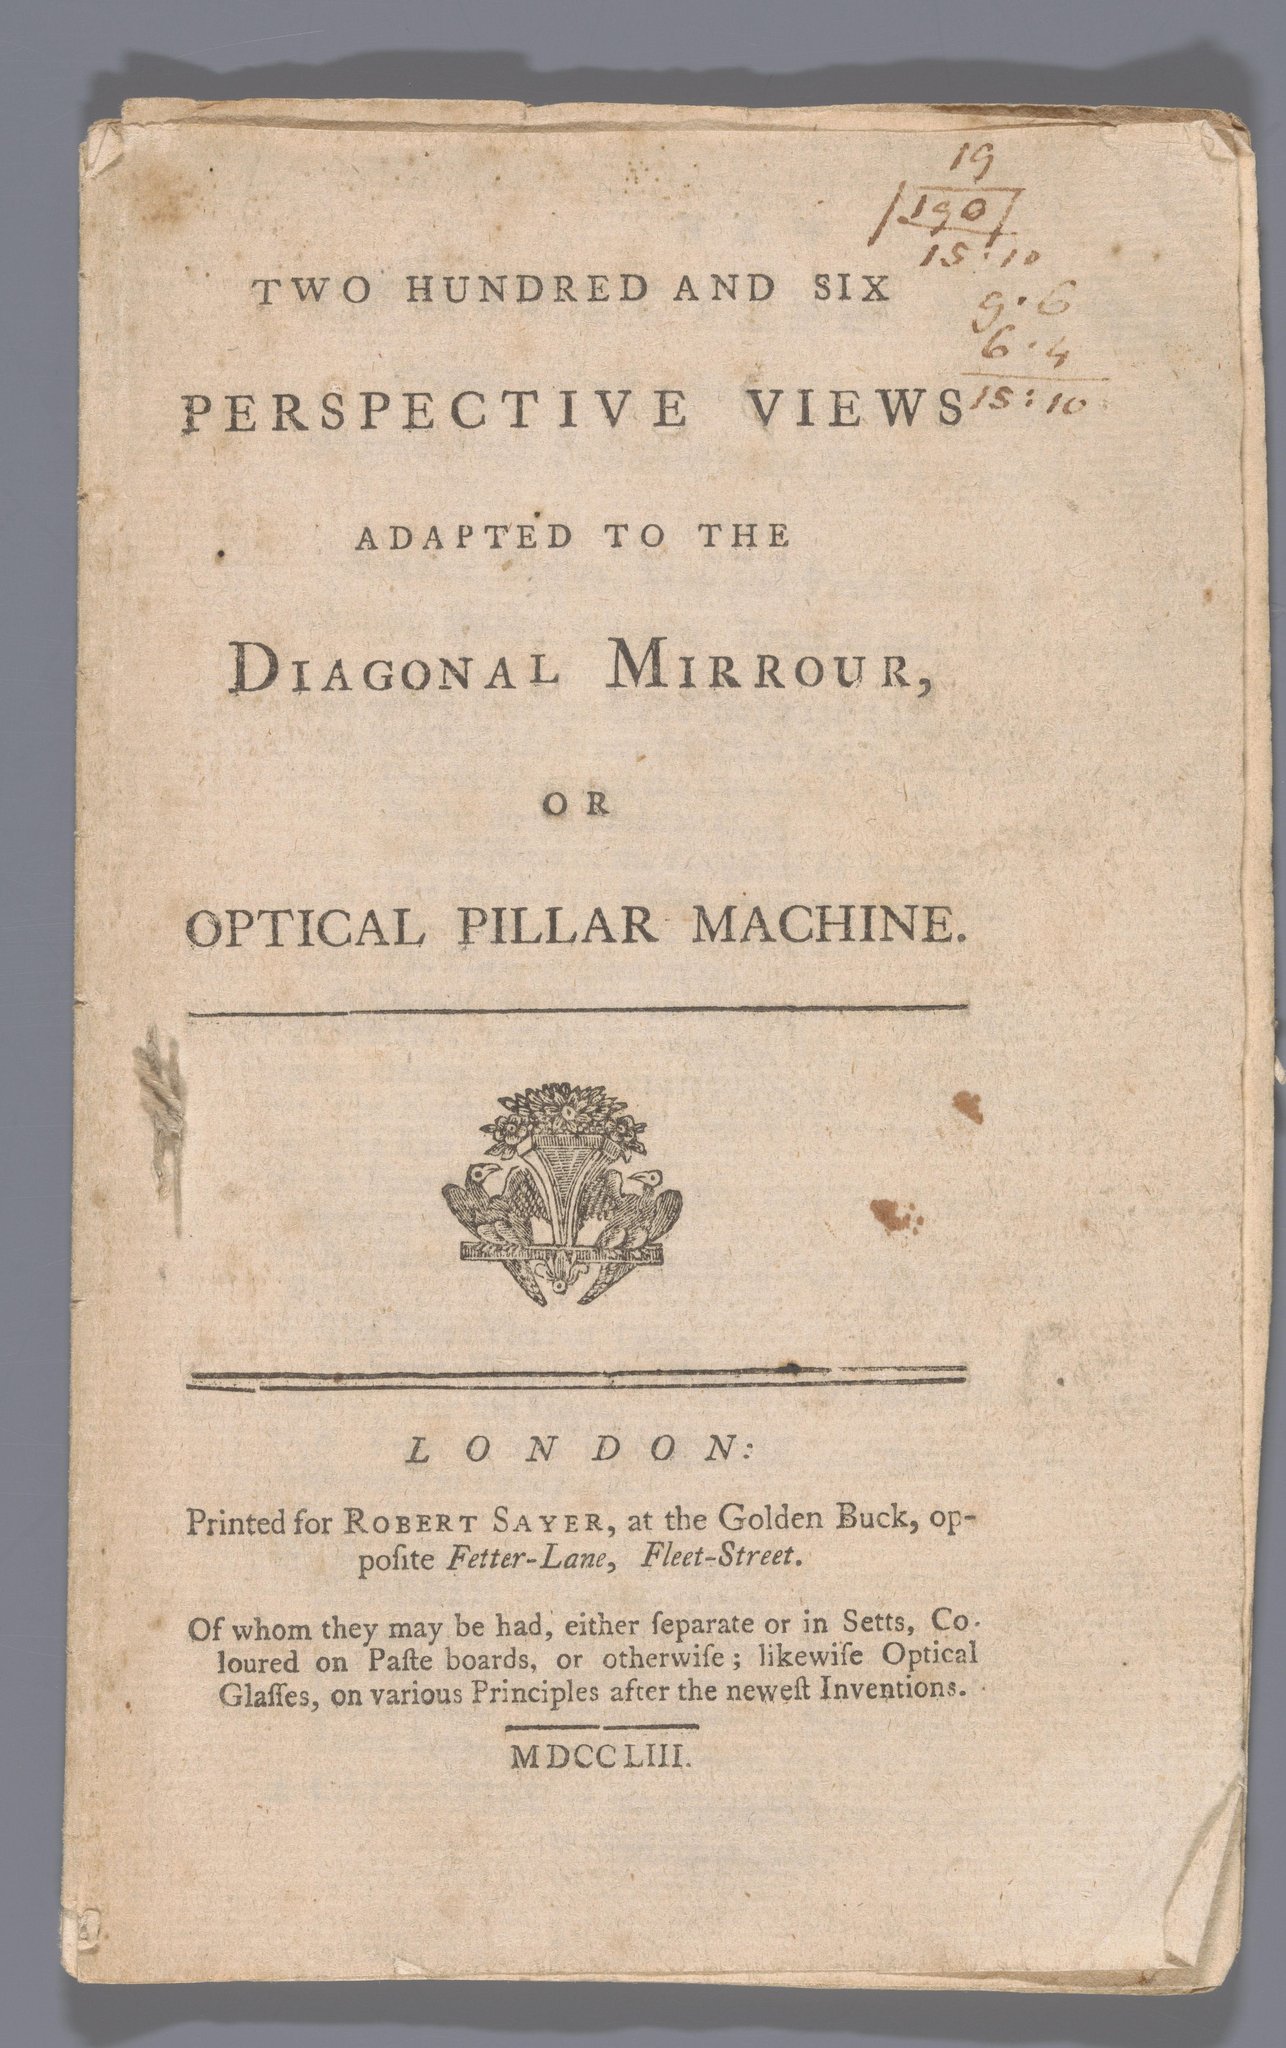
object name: catalog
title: Fondscatalogus met opticaprenten van de uitgever Robert Sayer te Londen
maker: robert sayer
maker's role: print maker, publisher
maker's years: 1724-1794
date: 1753-1755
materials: paper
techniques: letterpress printing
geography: london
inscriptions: annotation, annotation, annotation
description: Deze catalogus is mogelijk door de familie Six gebruikt om opticaprenten bij de Londense uitgever Robert Sayer te bestellen.